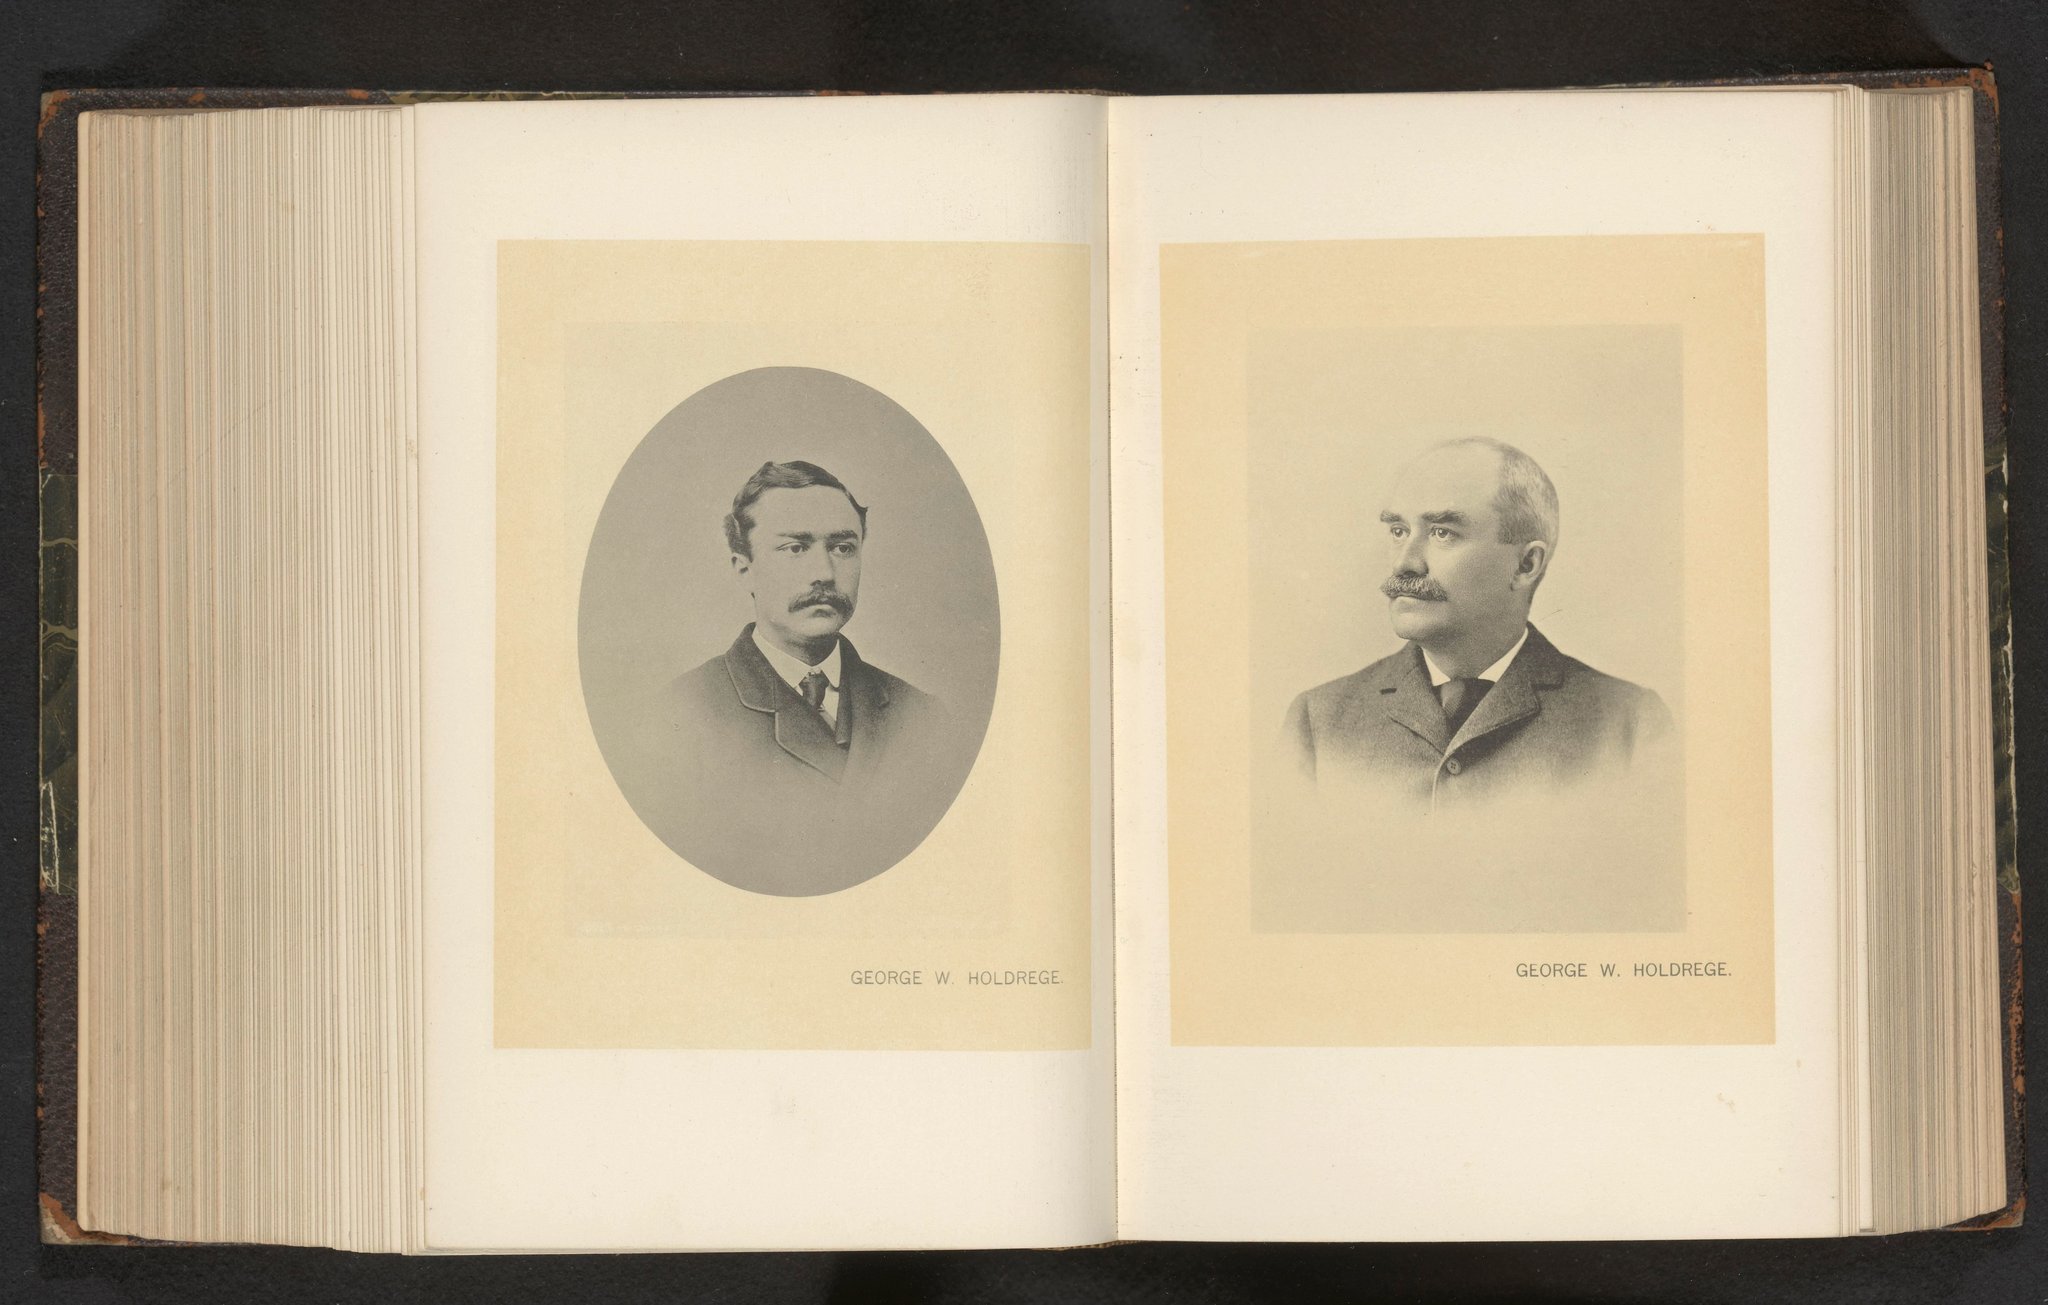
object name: page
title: George W. Holdrege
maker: Anonymous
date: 1869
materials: paper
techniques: photoaquatint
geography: boston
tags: adult man